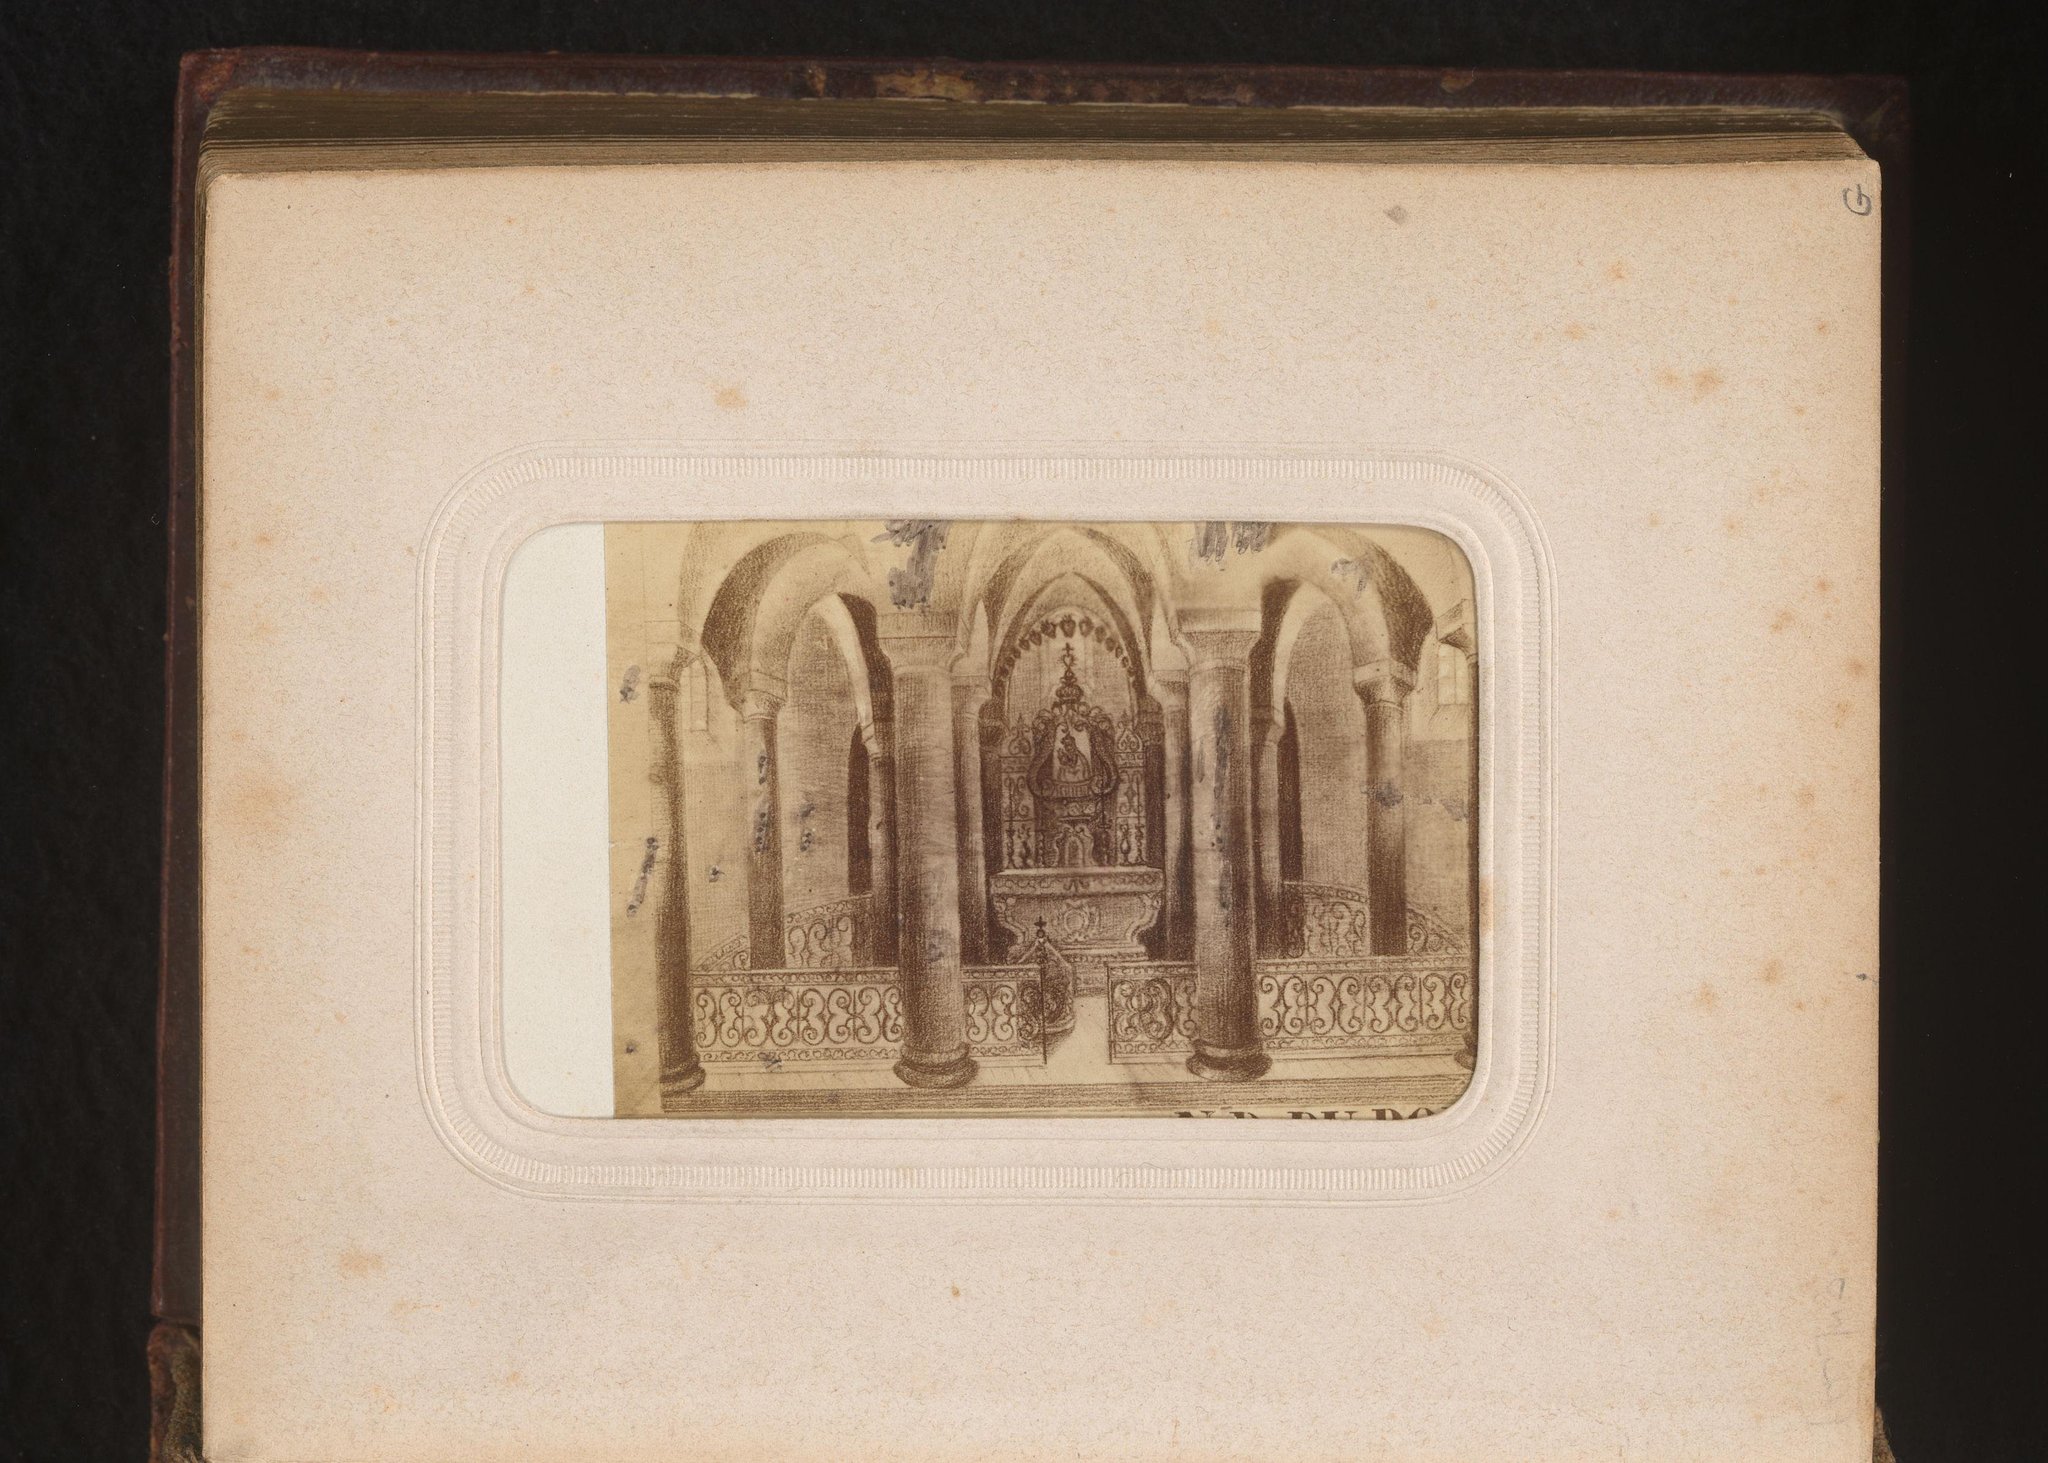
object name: carte de visite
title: Chapelle Souterraine de N. D. du Port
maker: Anonymous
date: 1860-1900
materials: cardboard, photographic support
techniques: albumen print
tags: parts of church interior: chapel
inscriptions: inscription: ‘J[.]p[.]se’